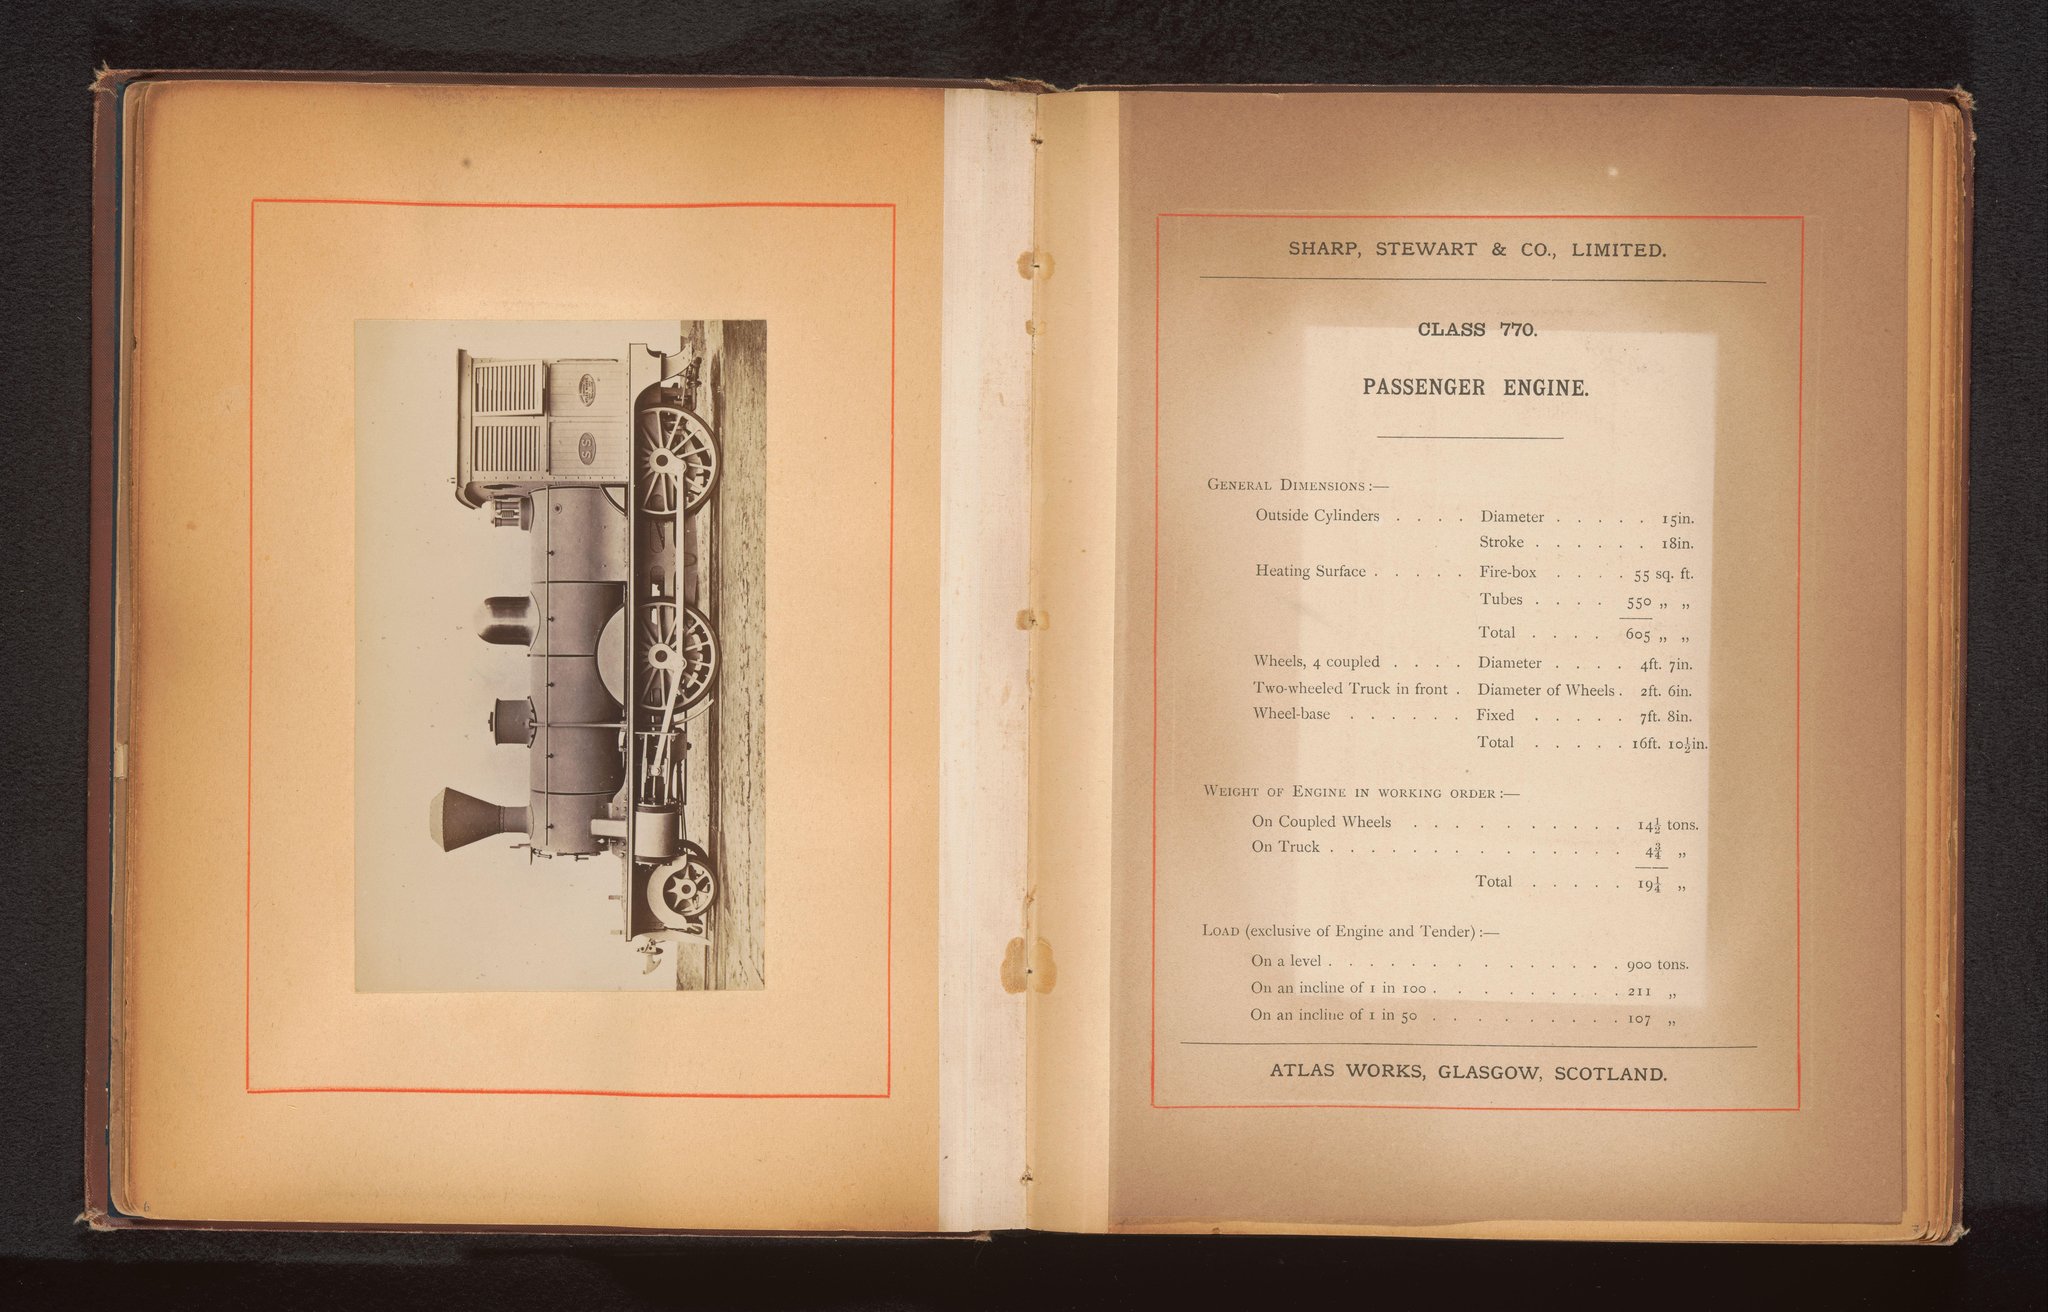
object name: photograph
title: Stoomlocomotief voor personenvervoer gemaakt door Sharp, Stewart and Company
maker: Anonymous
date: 1874-1884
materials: photographic support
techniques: albumen print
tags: steam locomotive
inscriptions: number: ‘770’, inscription: ‘Class 770. Passenger engine.’